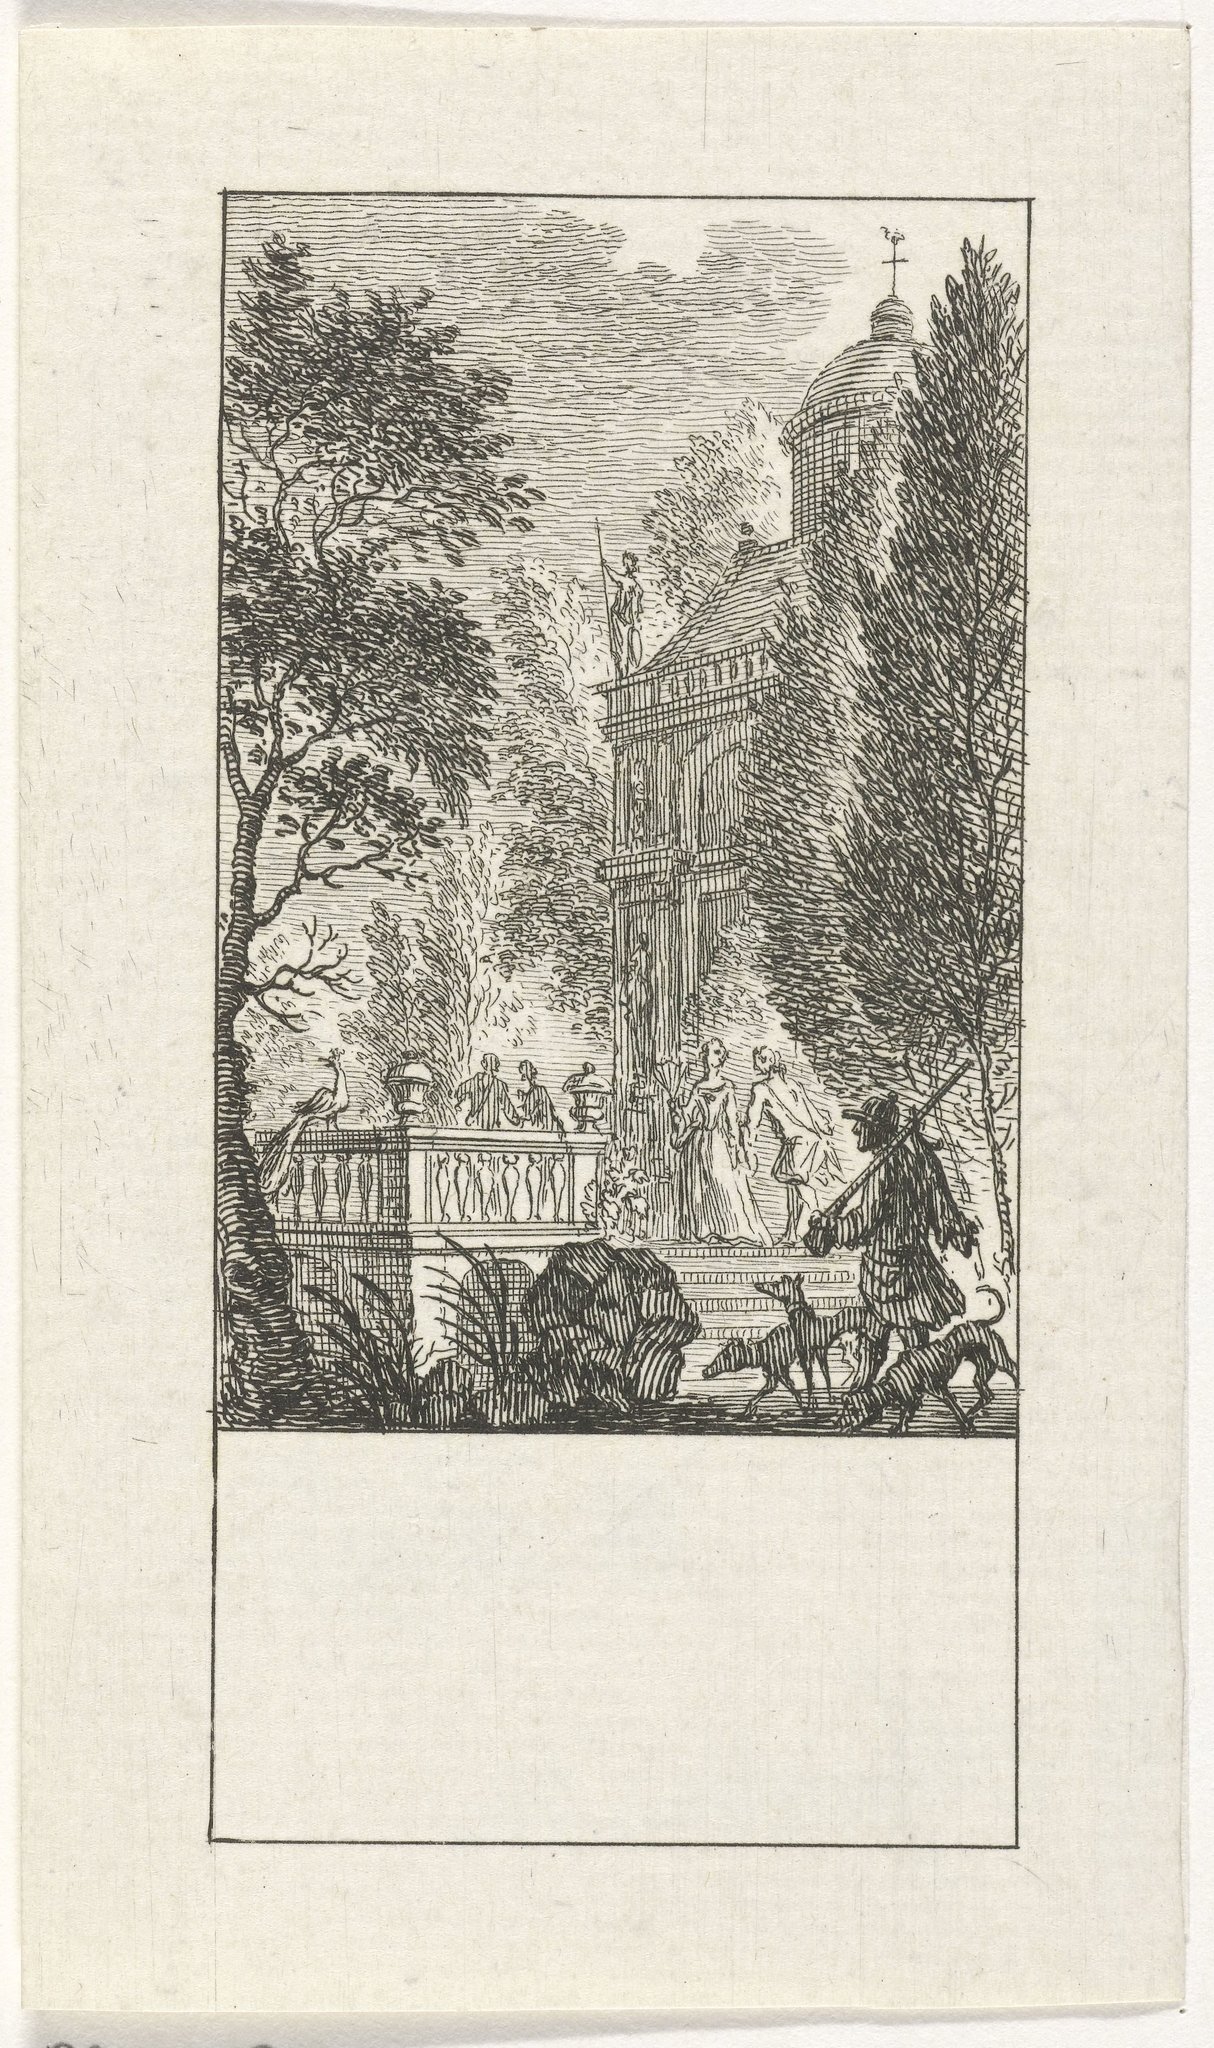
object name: print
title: De twaalf maanden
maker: simon fokke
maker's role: draughtsman, print maker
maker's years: 1712-1784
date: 1722-1784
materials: paper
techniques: etching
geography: amsterdam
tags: september ~ other concepts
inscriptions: collector's mark: Lugt 240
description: Uit een serie van twaalf prenten, de verbeelding van de maand september. Figuren op het terras van een villa. Op de voorgrond loopt een jager met zijn jachthonden, op zijn schouder draagt hij een stok waaraan het geschoten wild hangt.